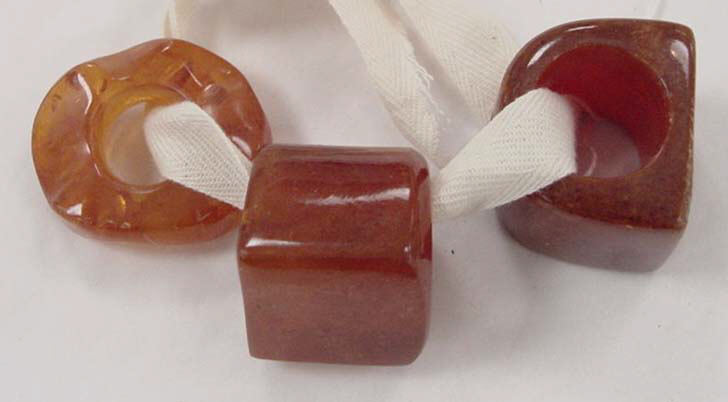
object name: jewelry set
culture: chinese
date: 1801-1900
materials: amber